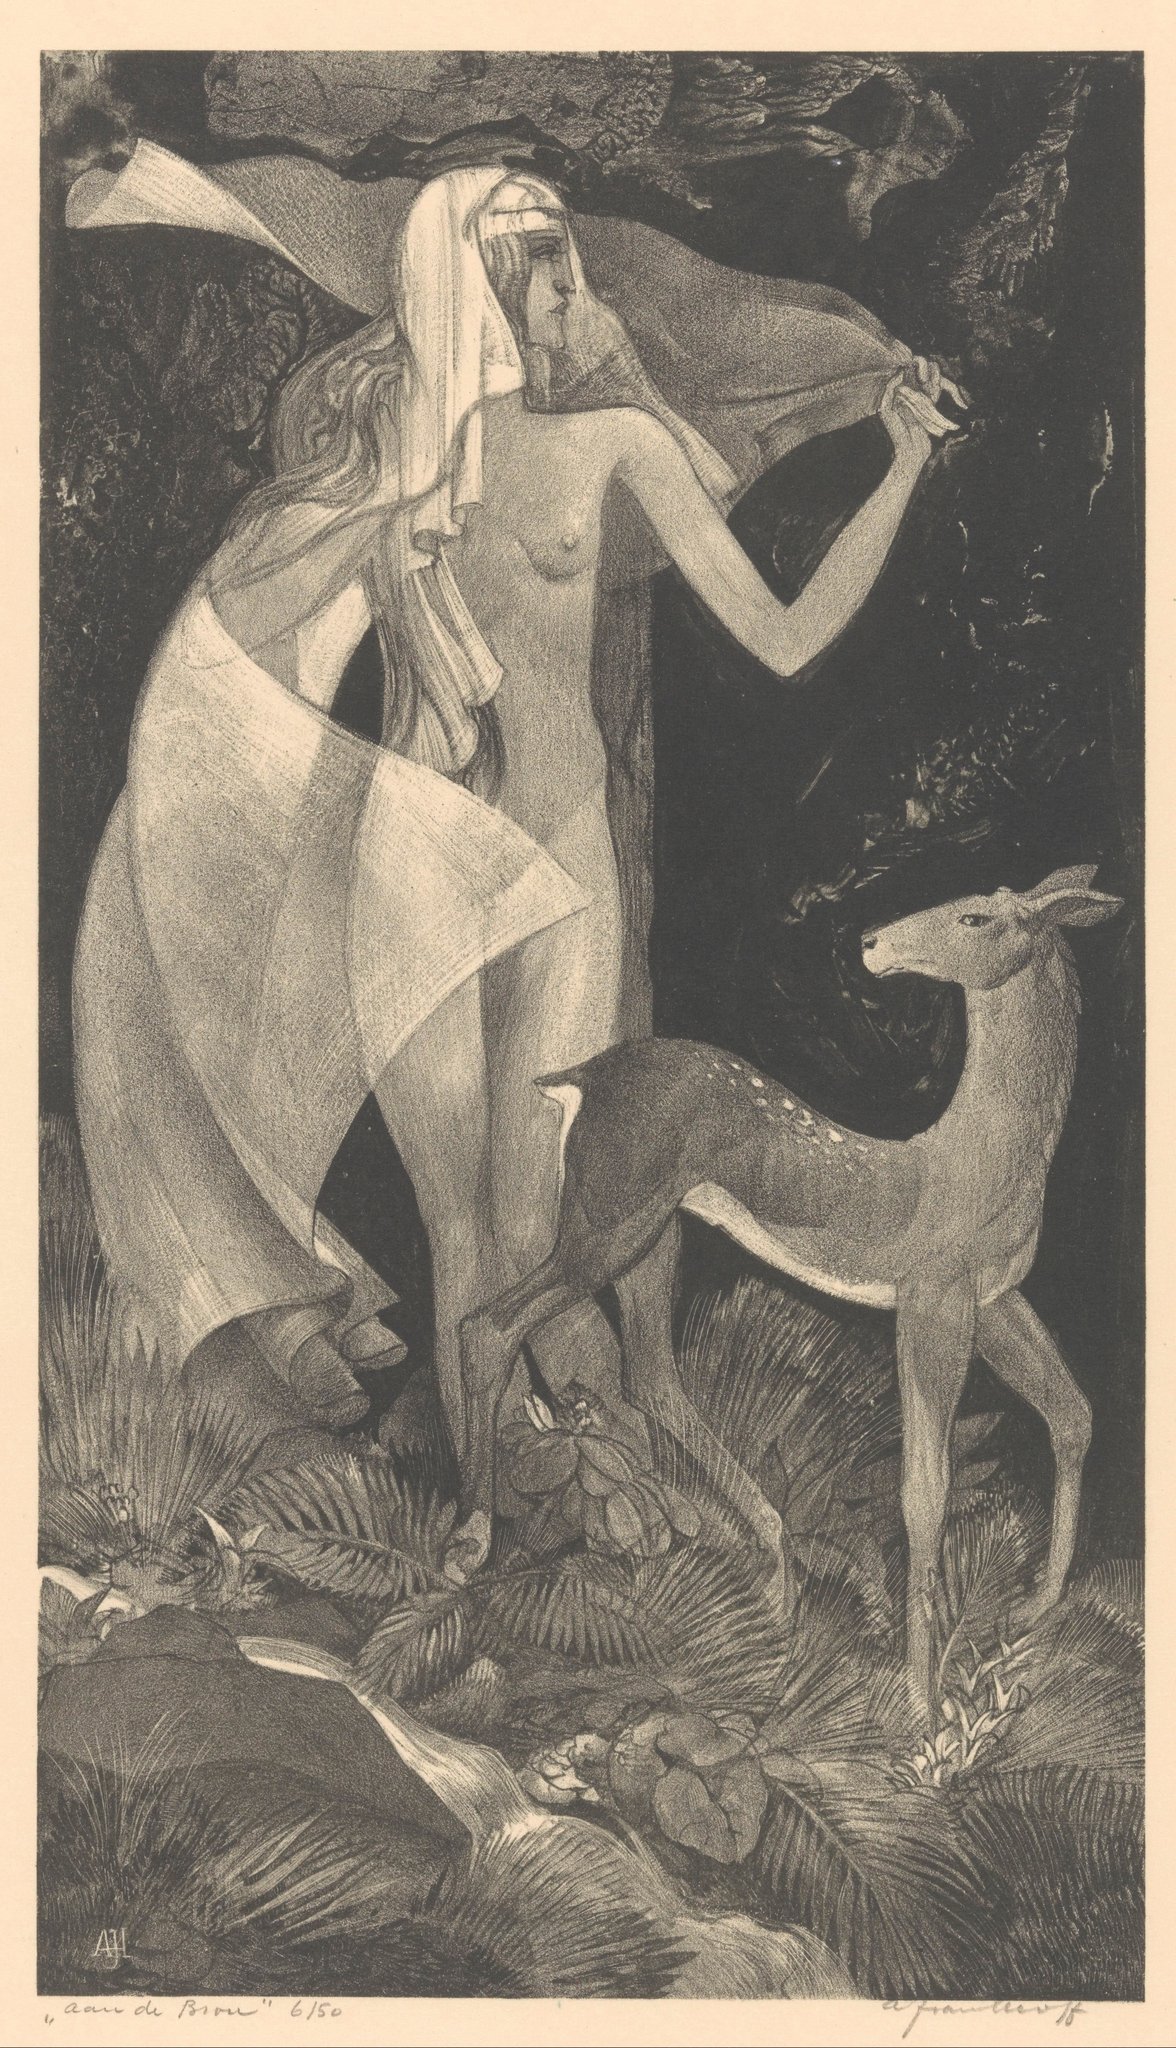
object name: print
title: Aan de bron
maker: adriaan j. van t hoff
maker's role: draughtsman, print maker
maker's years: 1893-1939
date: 1908-1932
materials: paper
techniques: lithograph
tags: hoofed animals: deer, woman (showing herself) undressed, quasi-nude, spring, source of river or stream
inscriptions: collector's mark: Lugt 2228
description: Een naakte vrouw en een hert staan bij een beek. De vrouw heeft een wapperende doek om haar schouders geslagen.